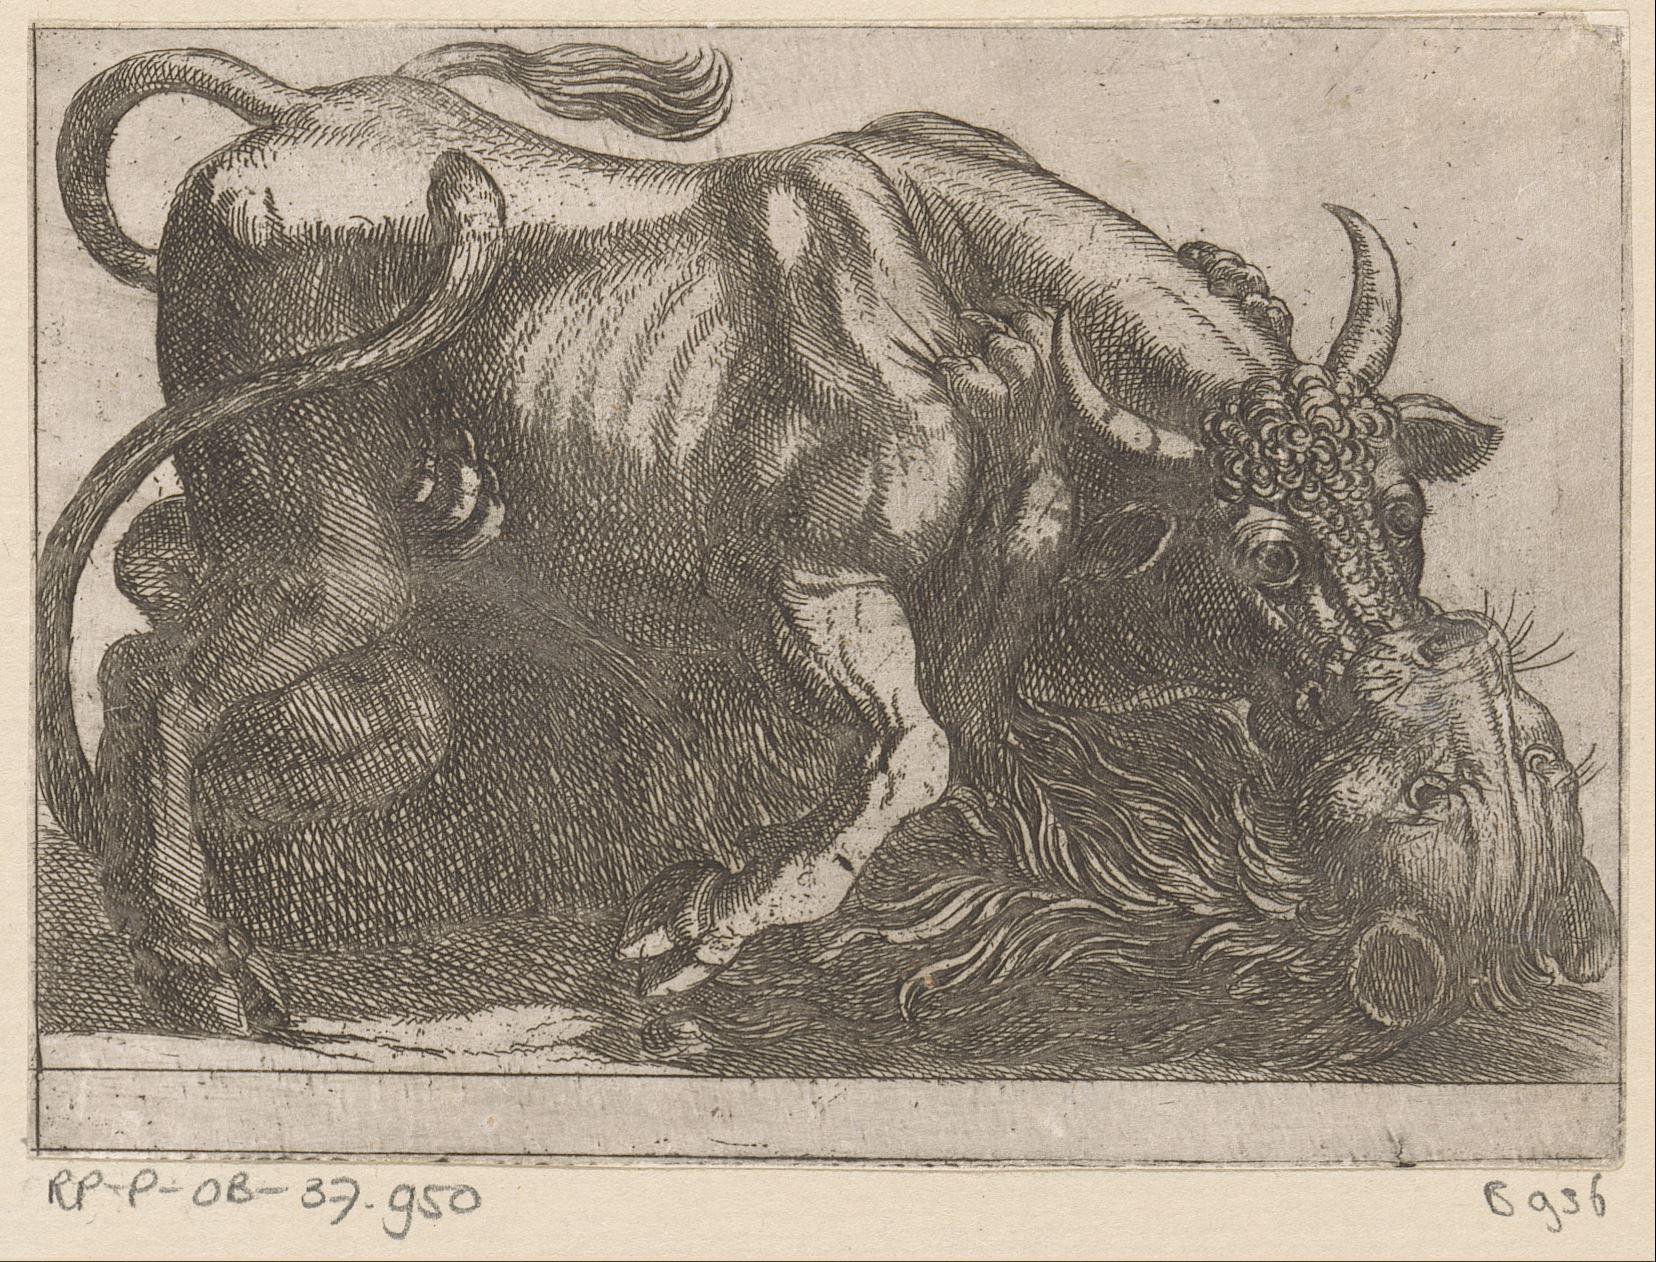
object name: print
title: Vechtende dieren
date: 1600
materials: paper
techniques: etching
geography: rome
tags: bull, beasts of prey, predatory animals: lion, fighting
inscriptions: collector's mark: Lugt 240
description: Deze prent maakt deel uit van een reeks van 25 prenten (+ titelprent) van vechtende dieren.